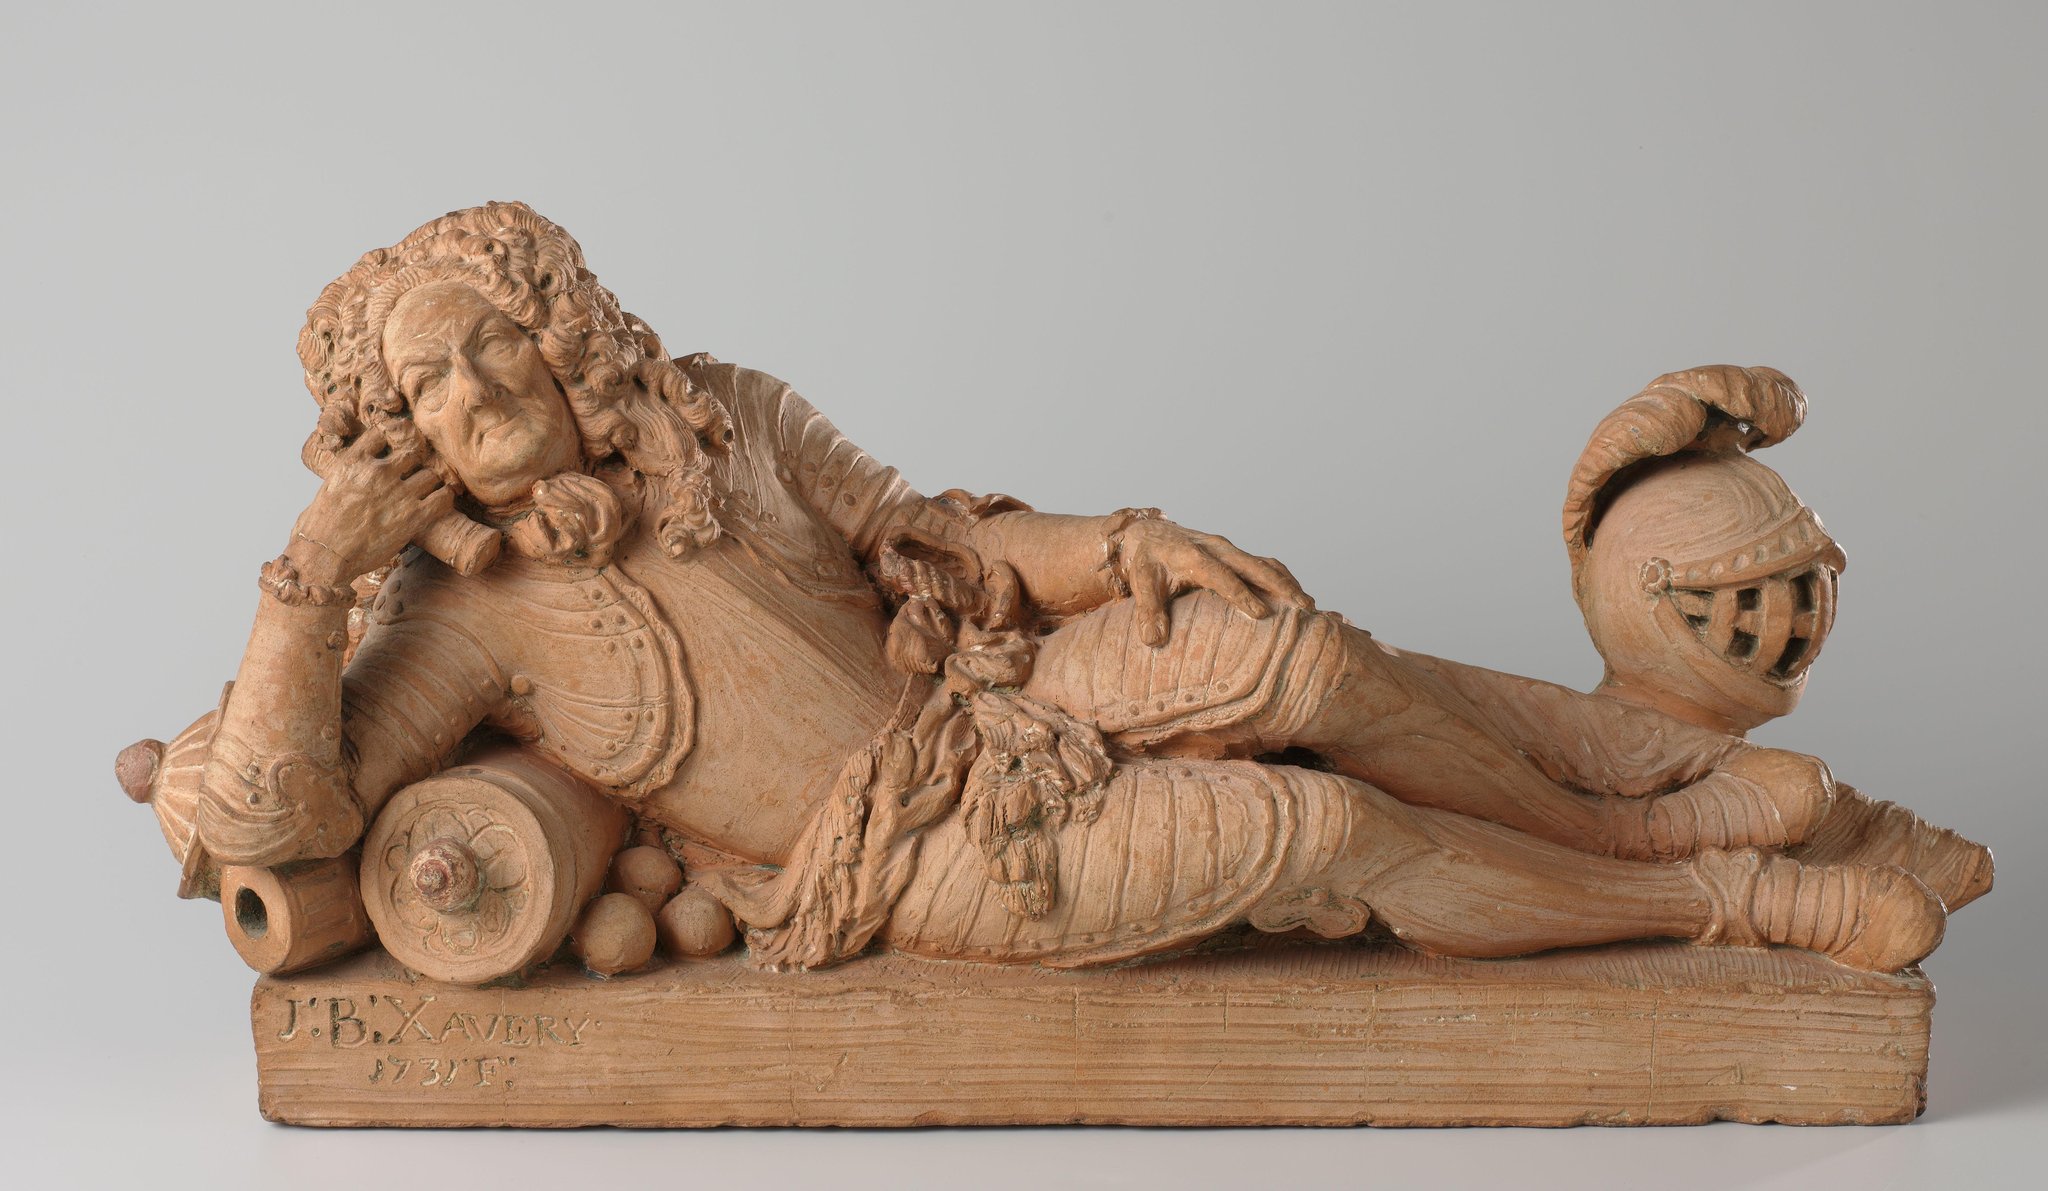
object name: sculpture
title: Model for the Funerary Monument of Lieutenant-General Baron Johan Theodoor Von Friesheim (1642-1733)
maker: jan baptist xavery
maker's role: sculptor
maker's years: 1697-1742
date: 1731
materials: terracotta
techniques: modeling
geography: the hague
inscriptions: signature and date, on the left side of the plinth, incised in the wet clay: ‘J:B: XAVERY / 1731. F:’